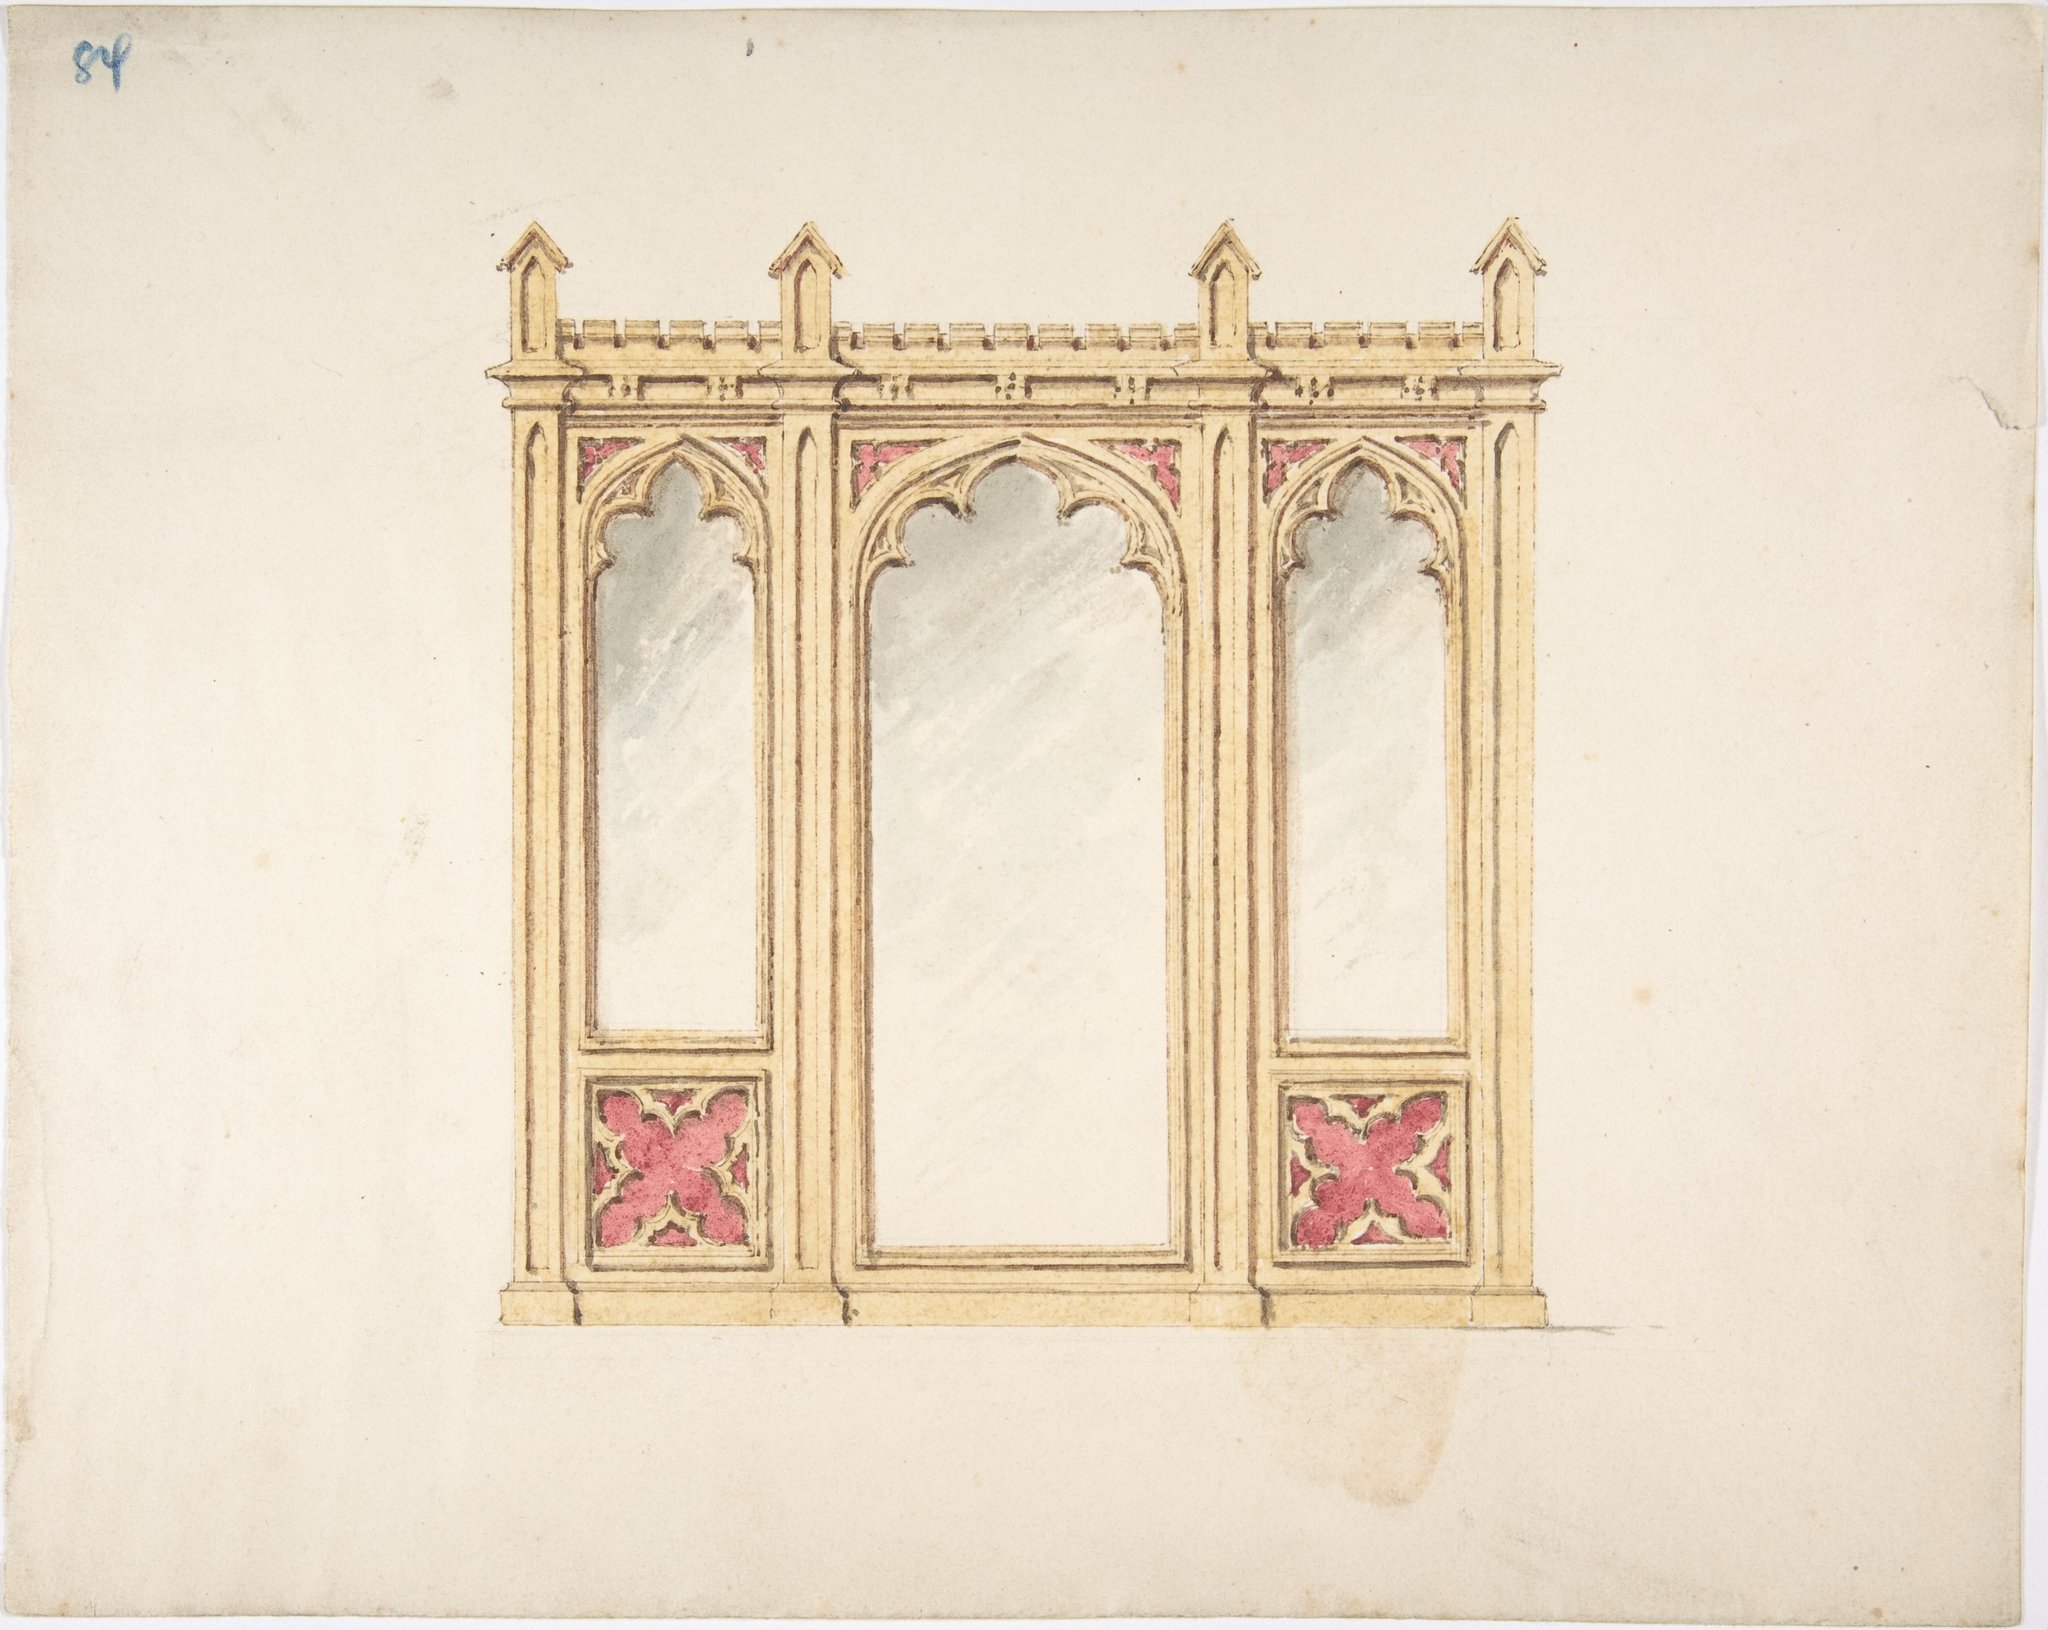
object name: drawing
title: Design for Gothic Tracery and Paneling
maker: anonymous, british, 19th century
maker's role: artist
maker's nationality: british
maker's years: 1800-1900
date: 1801-1833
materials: ink, watercolor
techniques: brush, pen, wash